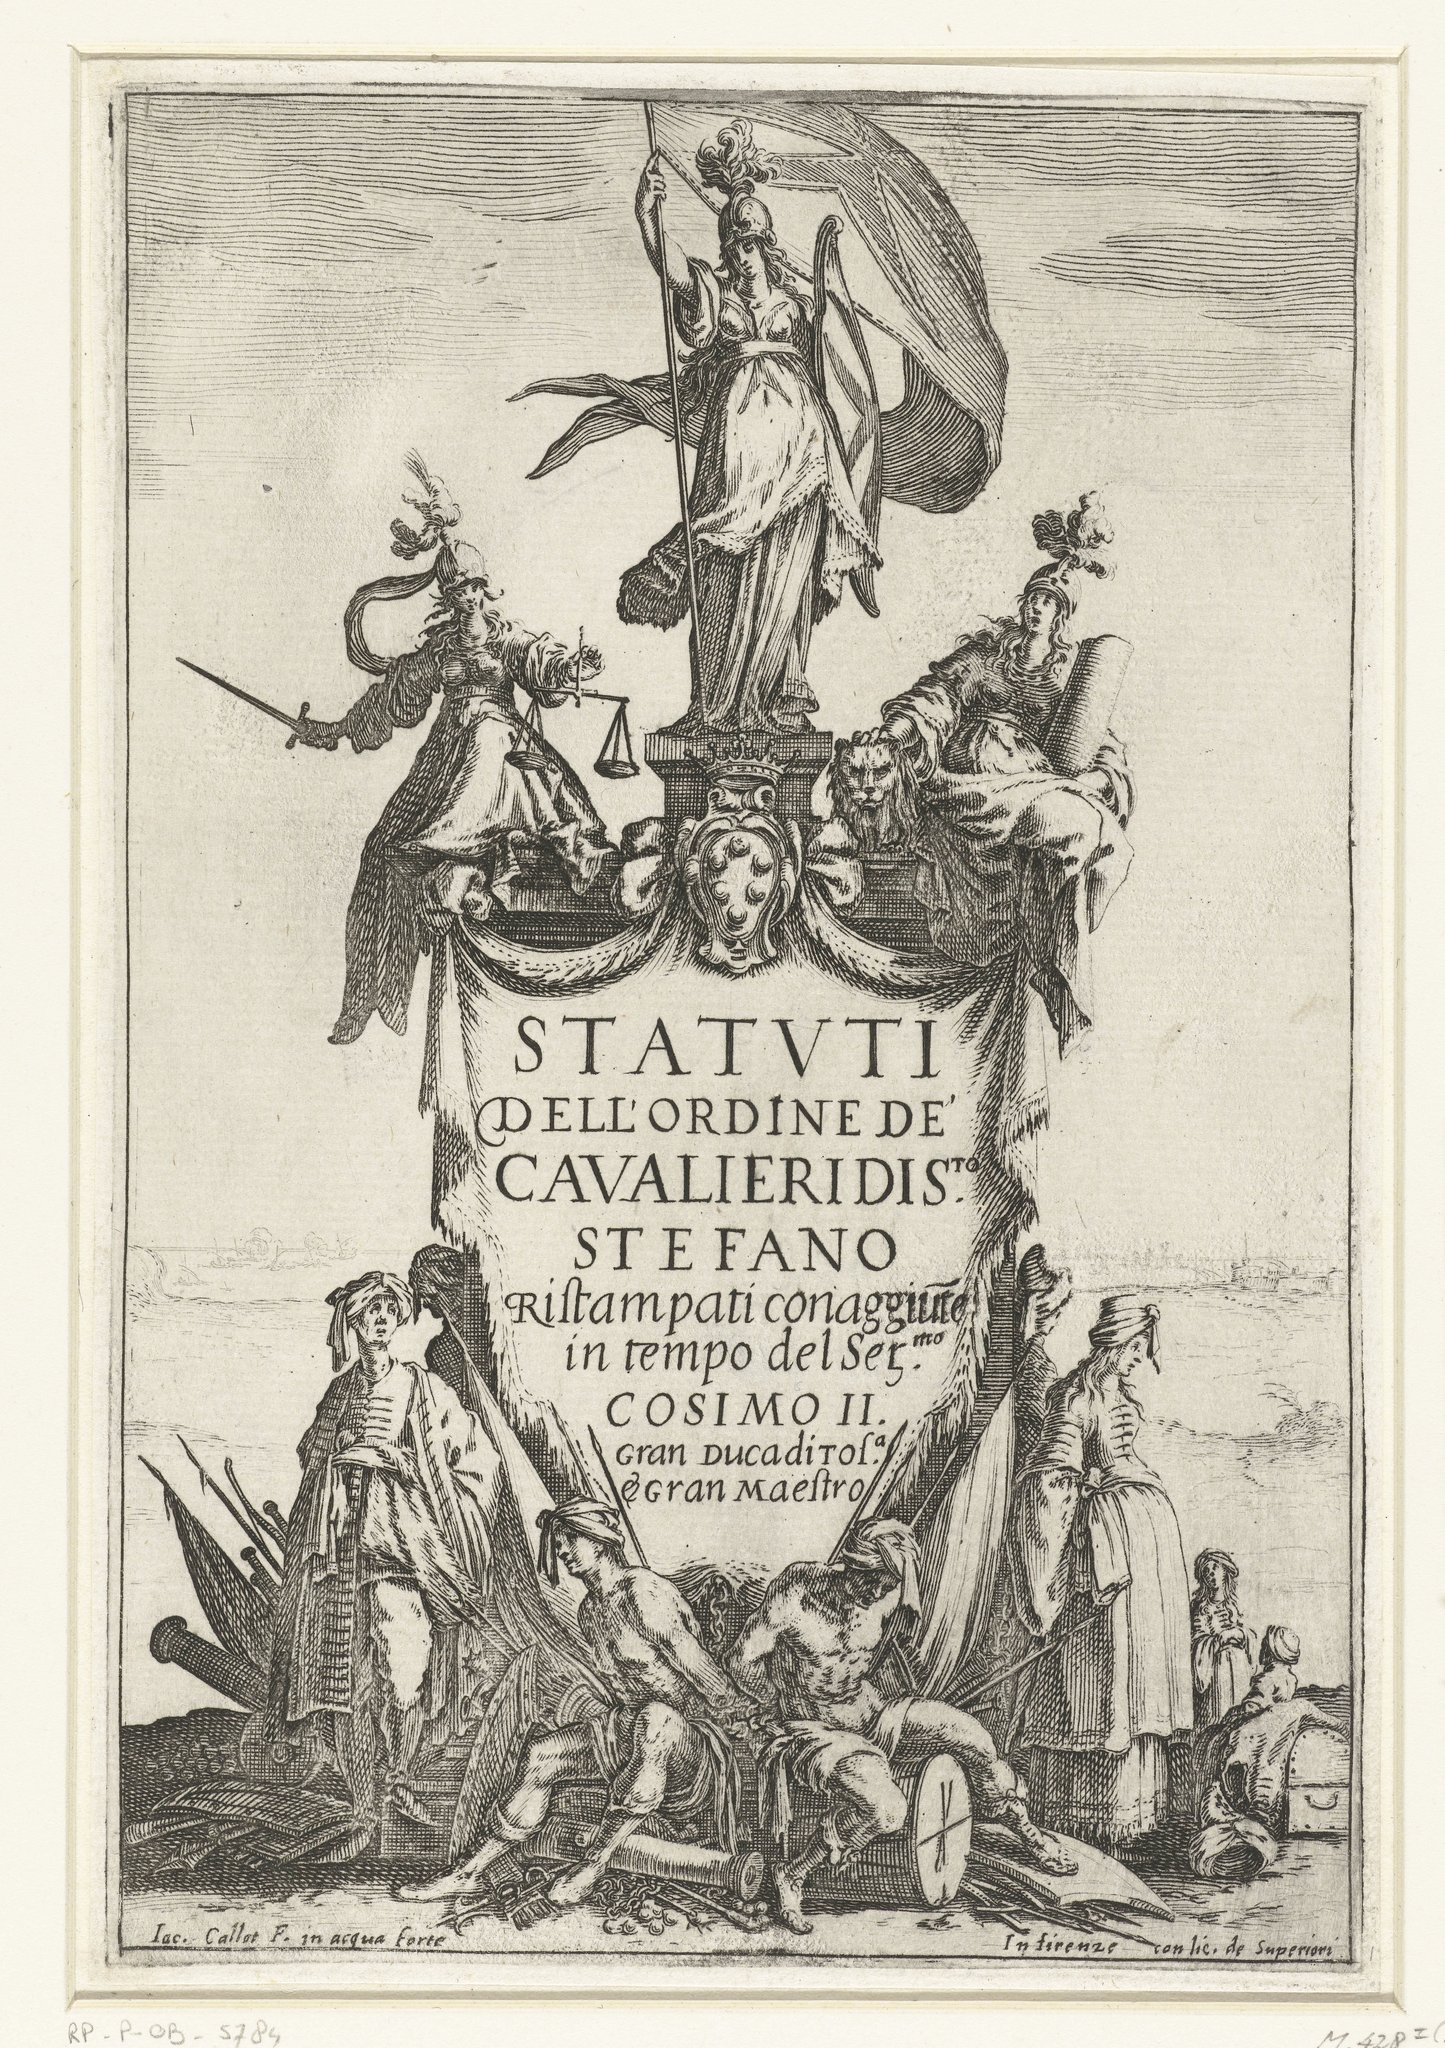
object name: titelblad, titelpagina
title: Statuti dell'ordine de' Cavalieri di Santo Stefano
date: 1620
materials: paper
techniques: etching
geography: florence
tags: fortitude, 'fortitudo' ~ one of the four cardinal virtues, justice, 'justitia'; 'giustitia divina' (ripa) ~ one of the four cardinal virtues, asiatic races and peoples: turks, title-page, monument, statue, military orders, e.g.: knights templars, knights of malta, teutonic knights ~ roman catholic church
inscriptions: collector's mark: Lugt 240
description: Latijnse tekst op een doek, bevestigd aan een monument met personificaties van rechtvaardigheid en kracht, en een dame met een vaandel en schild waarop het kruis van de Maltezer Ridders. Aan de voet van het monument wapentuig en Turkse gevangenen. Op versozijde lichte (tegen)afdruk van een ovale omlijsting met randschrift.